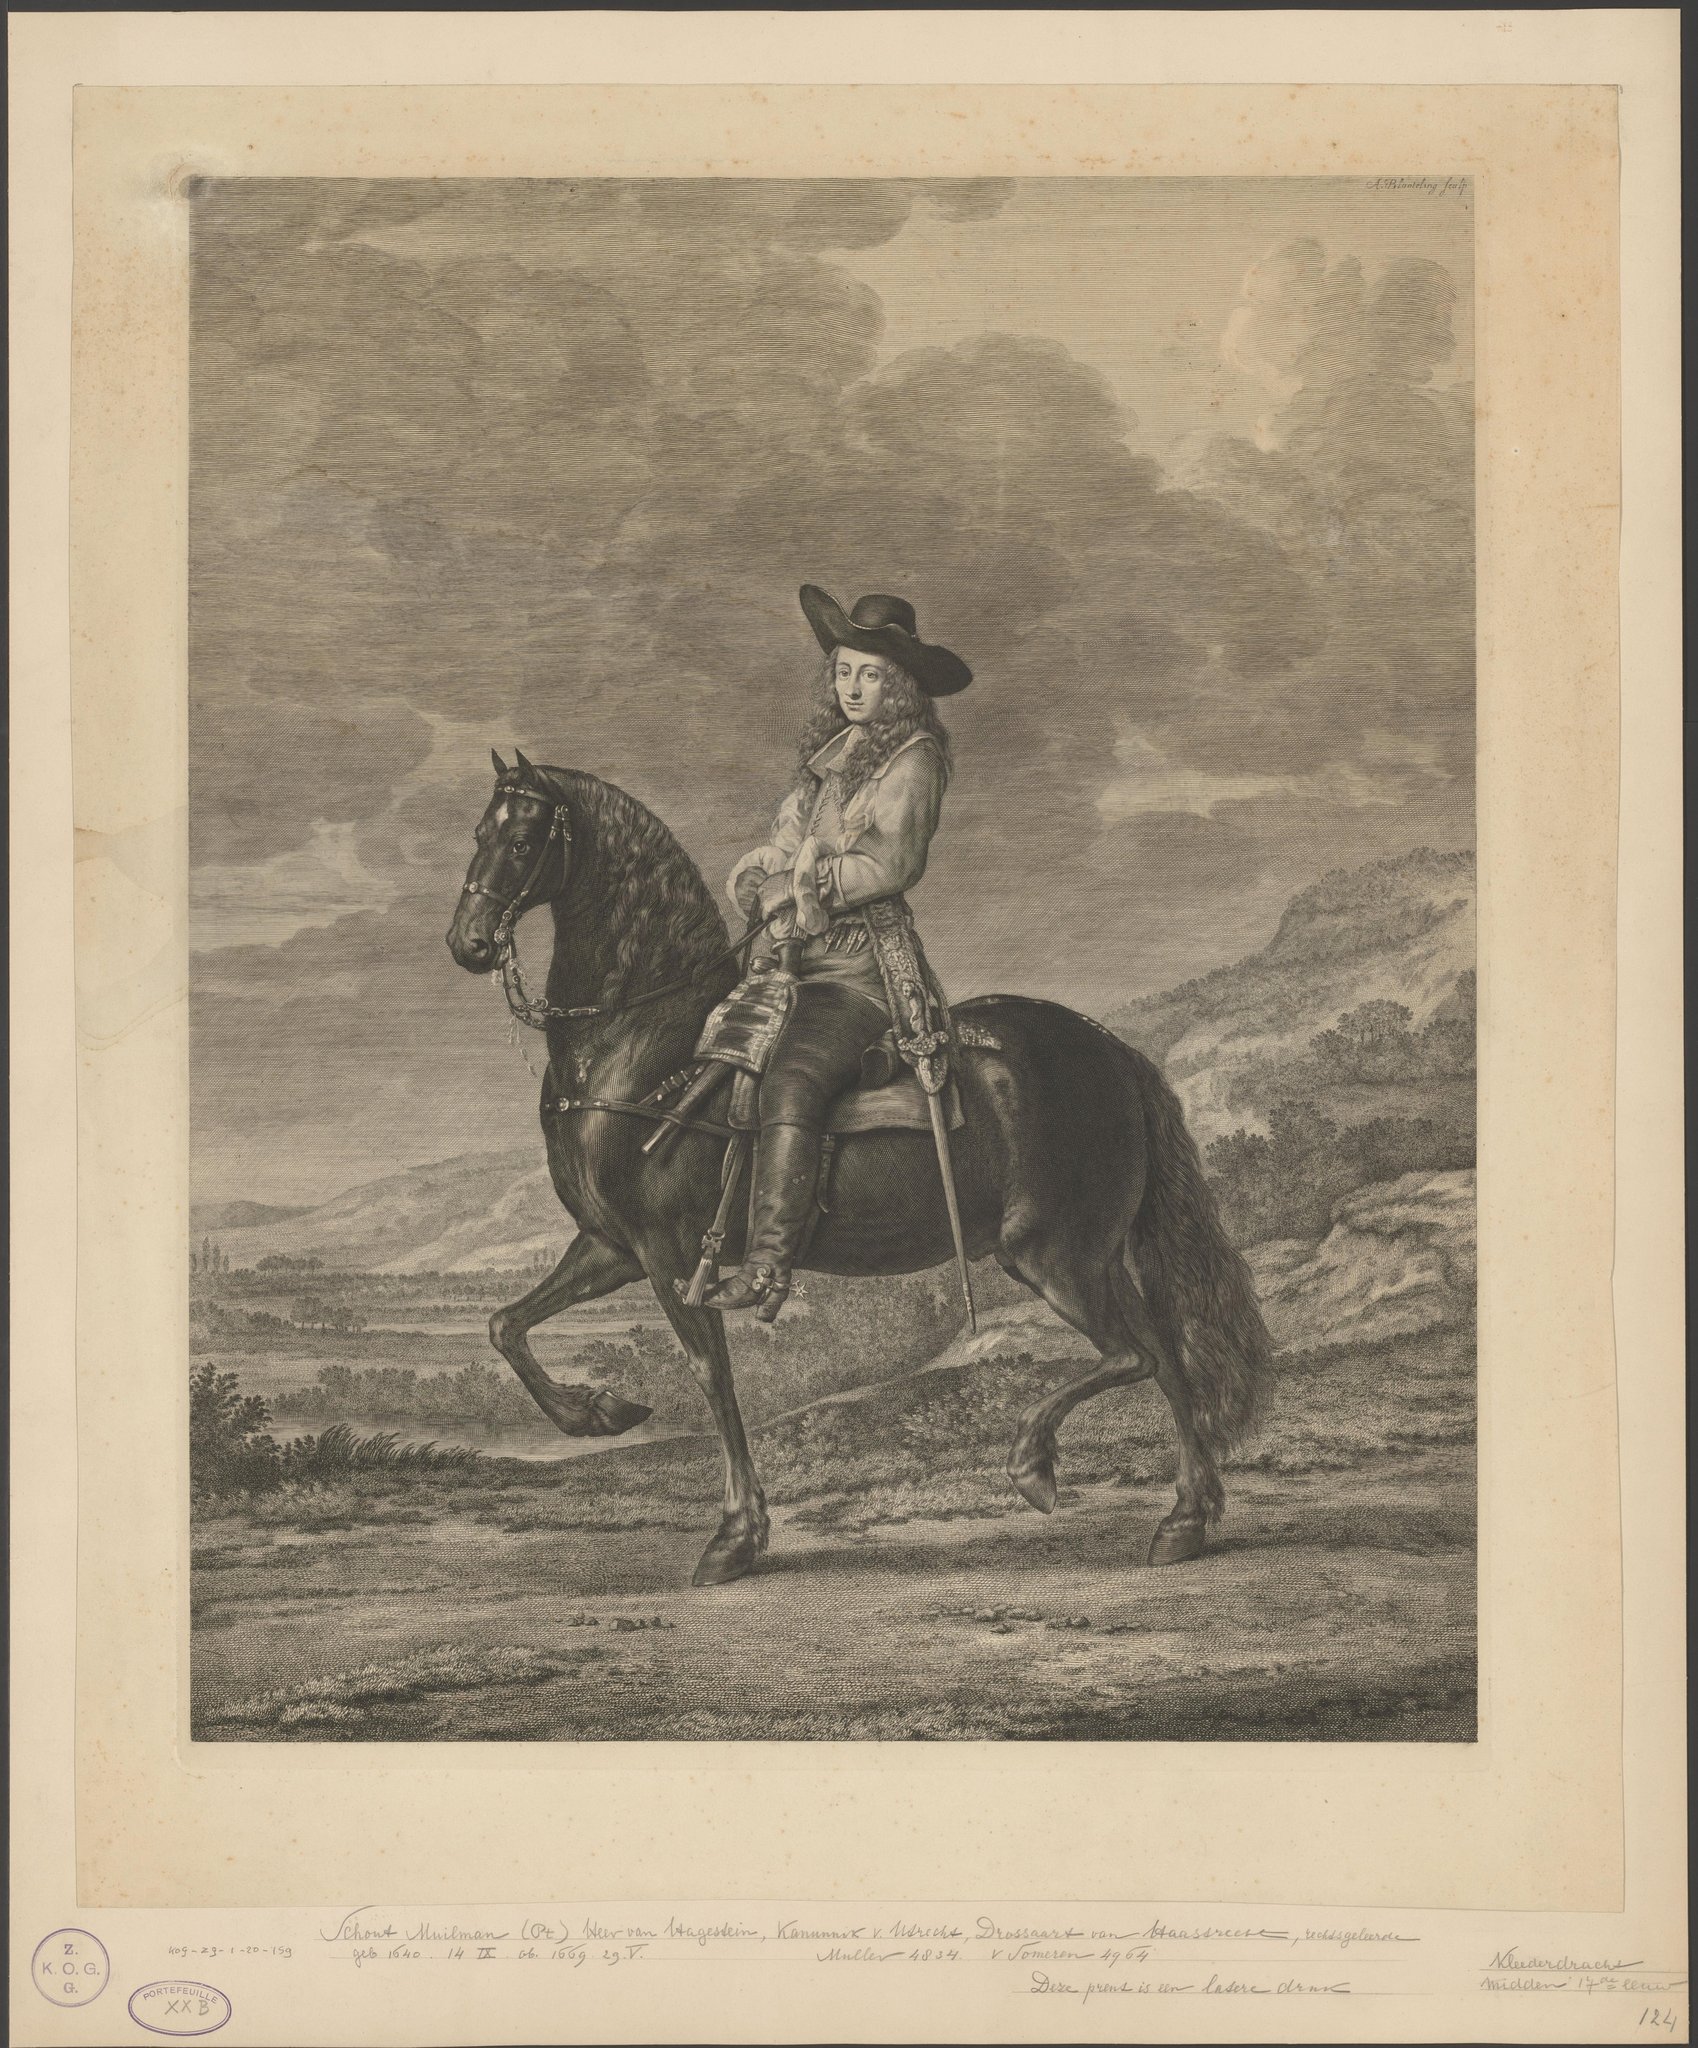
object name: print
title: Ruiterportret van Pieter Schout drost van Hagestein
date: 1660-1690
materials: paper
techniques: engraving, etching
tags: riding a horse, ass, or mule; rider, horseman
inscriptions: collector's mark: Lugt 1641, collector's mark: Lugt 1641, stamp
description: Portret van Pieter Schout drost van Hagestein te paard in een duinlandschap. Onderwerpsrubrieken binnen de Atlas Zeden en Gewoonten: Zeden en Gewoonten in Engeren Zin, De Kleeding, Kleederdrachten (tijdvakken), Het midden der 17de eeuw. (De Fransche mode).